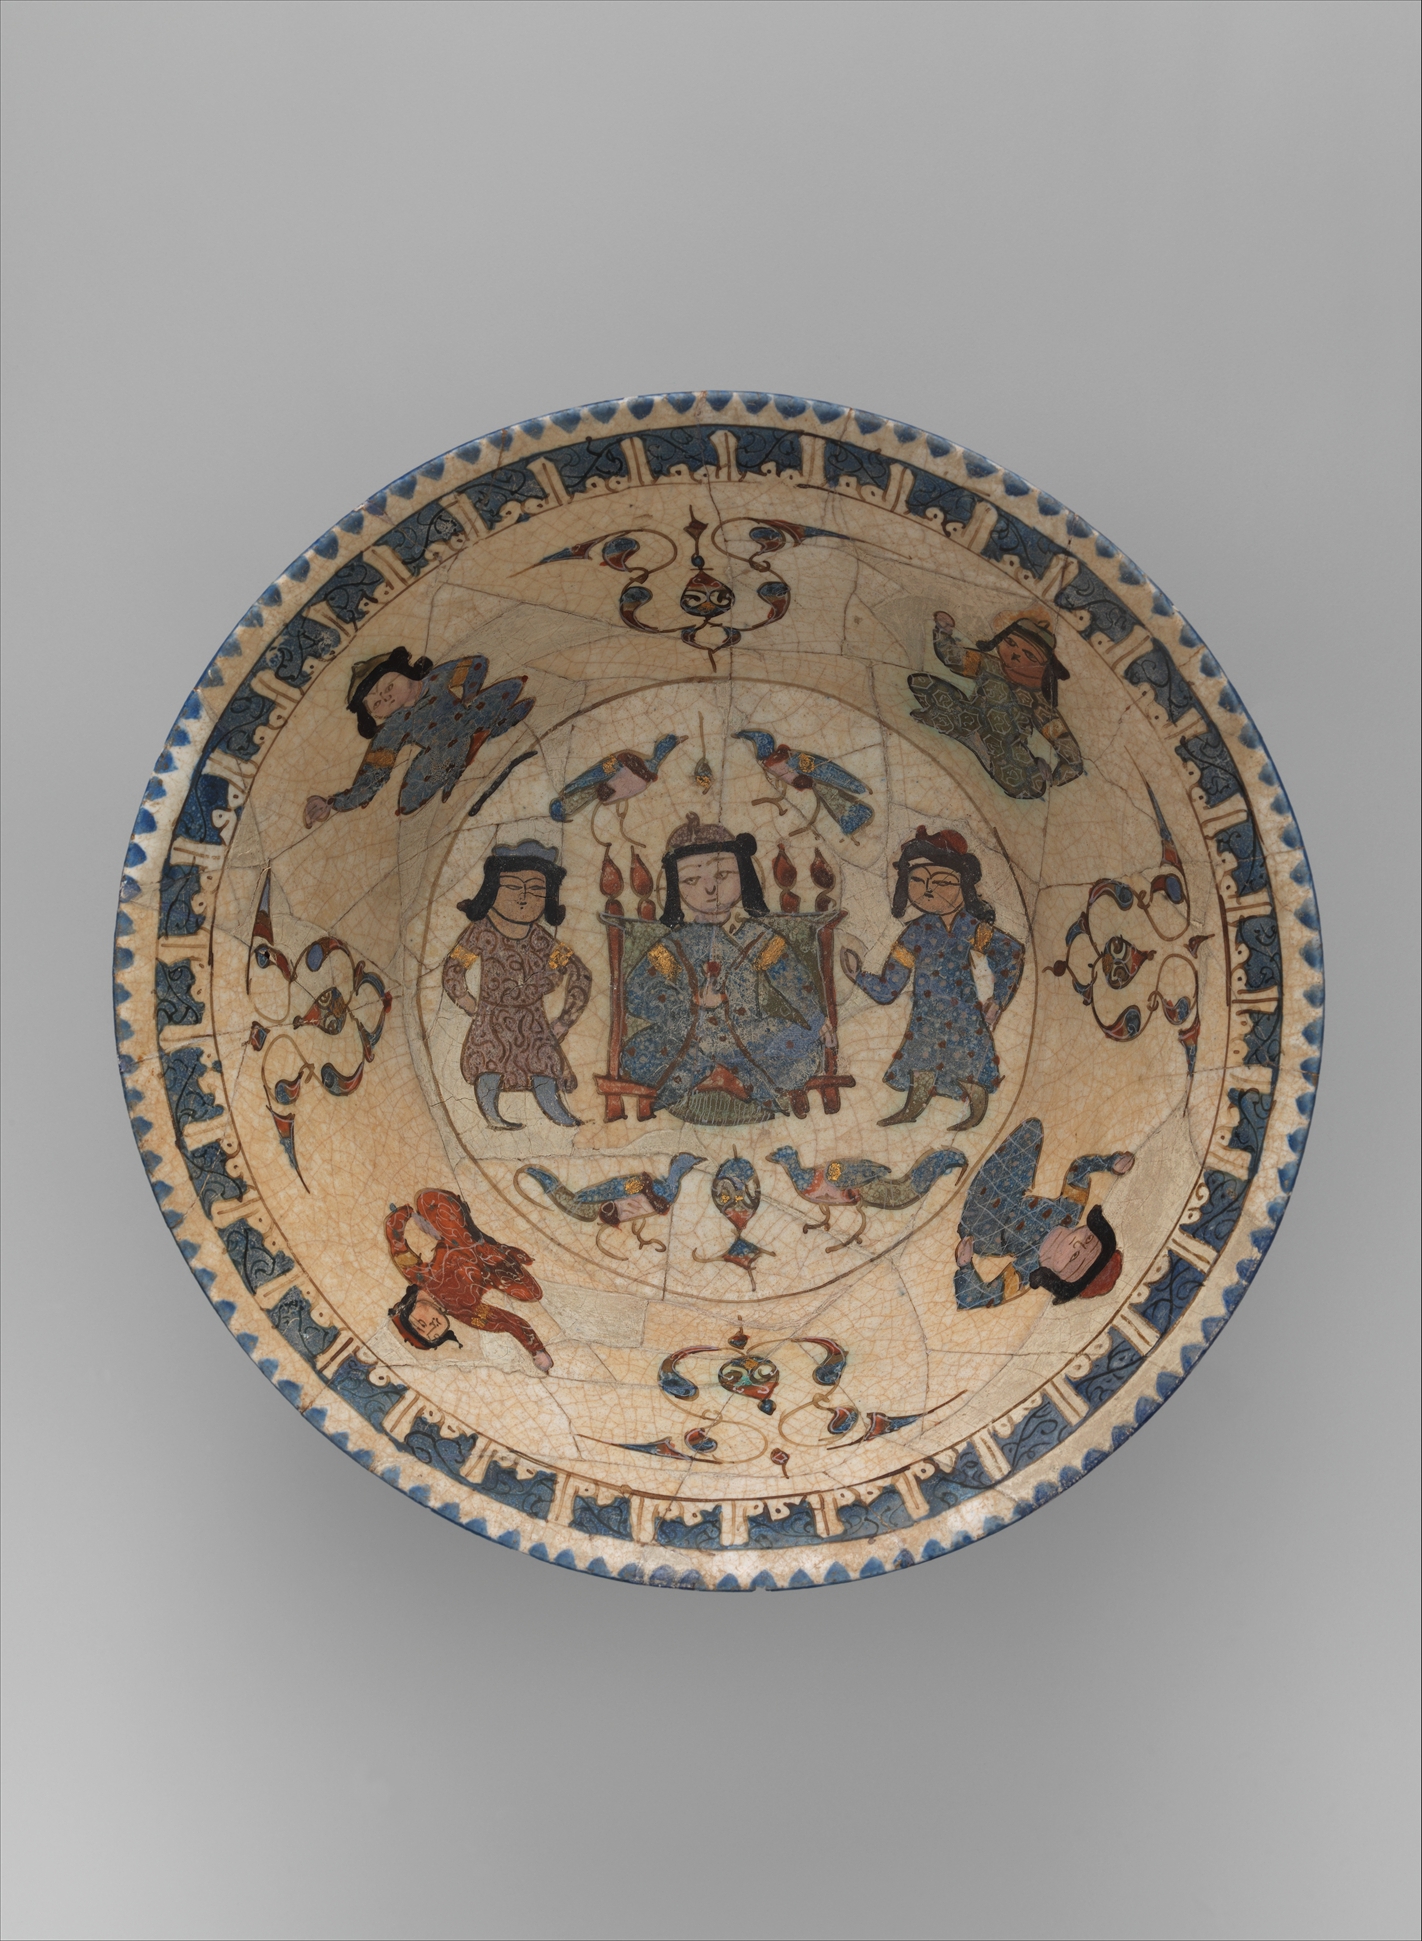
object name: bowl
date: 1101-1300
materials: stonepaste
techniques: overglaze, painting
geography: iran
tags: human figures,birds